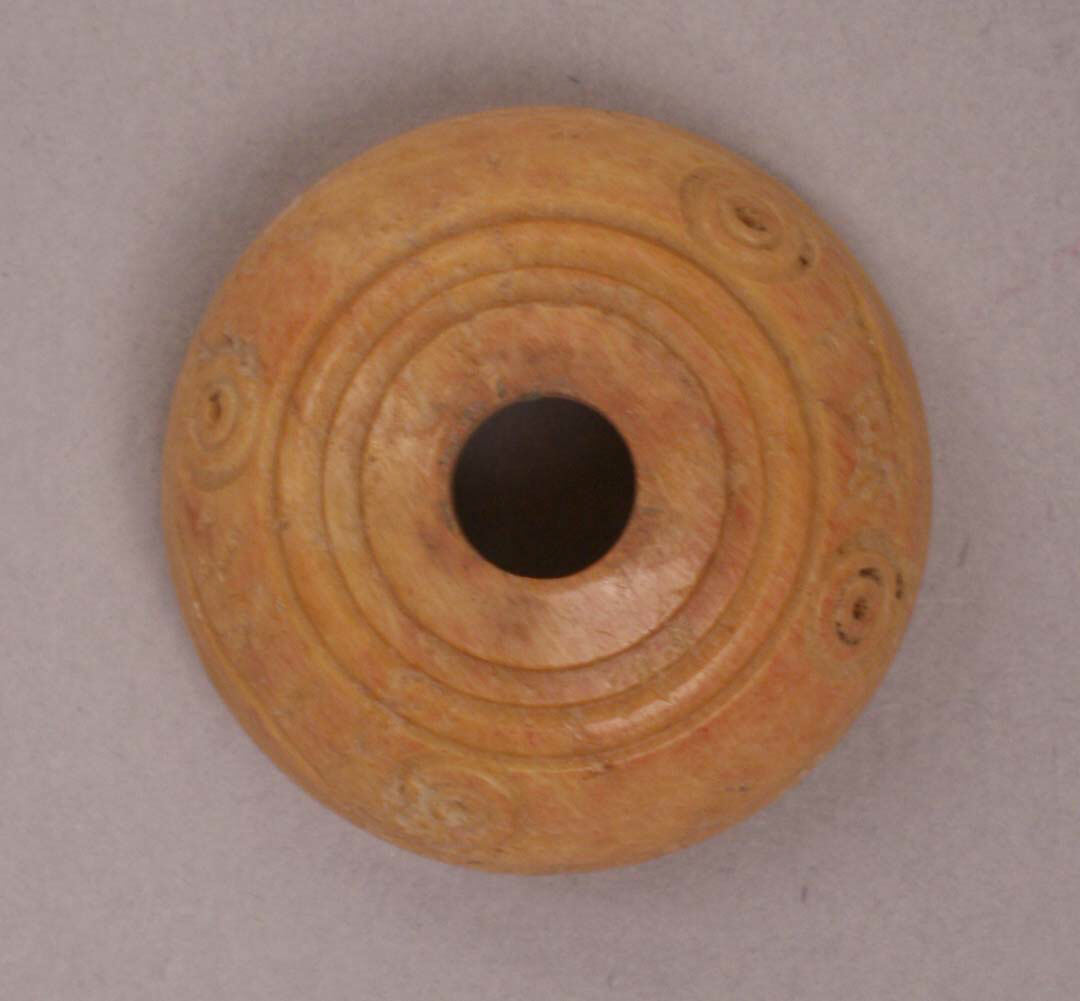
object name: button or bead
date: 801-1000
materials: bone, paint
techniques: incising, inlay, tinting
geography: iran